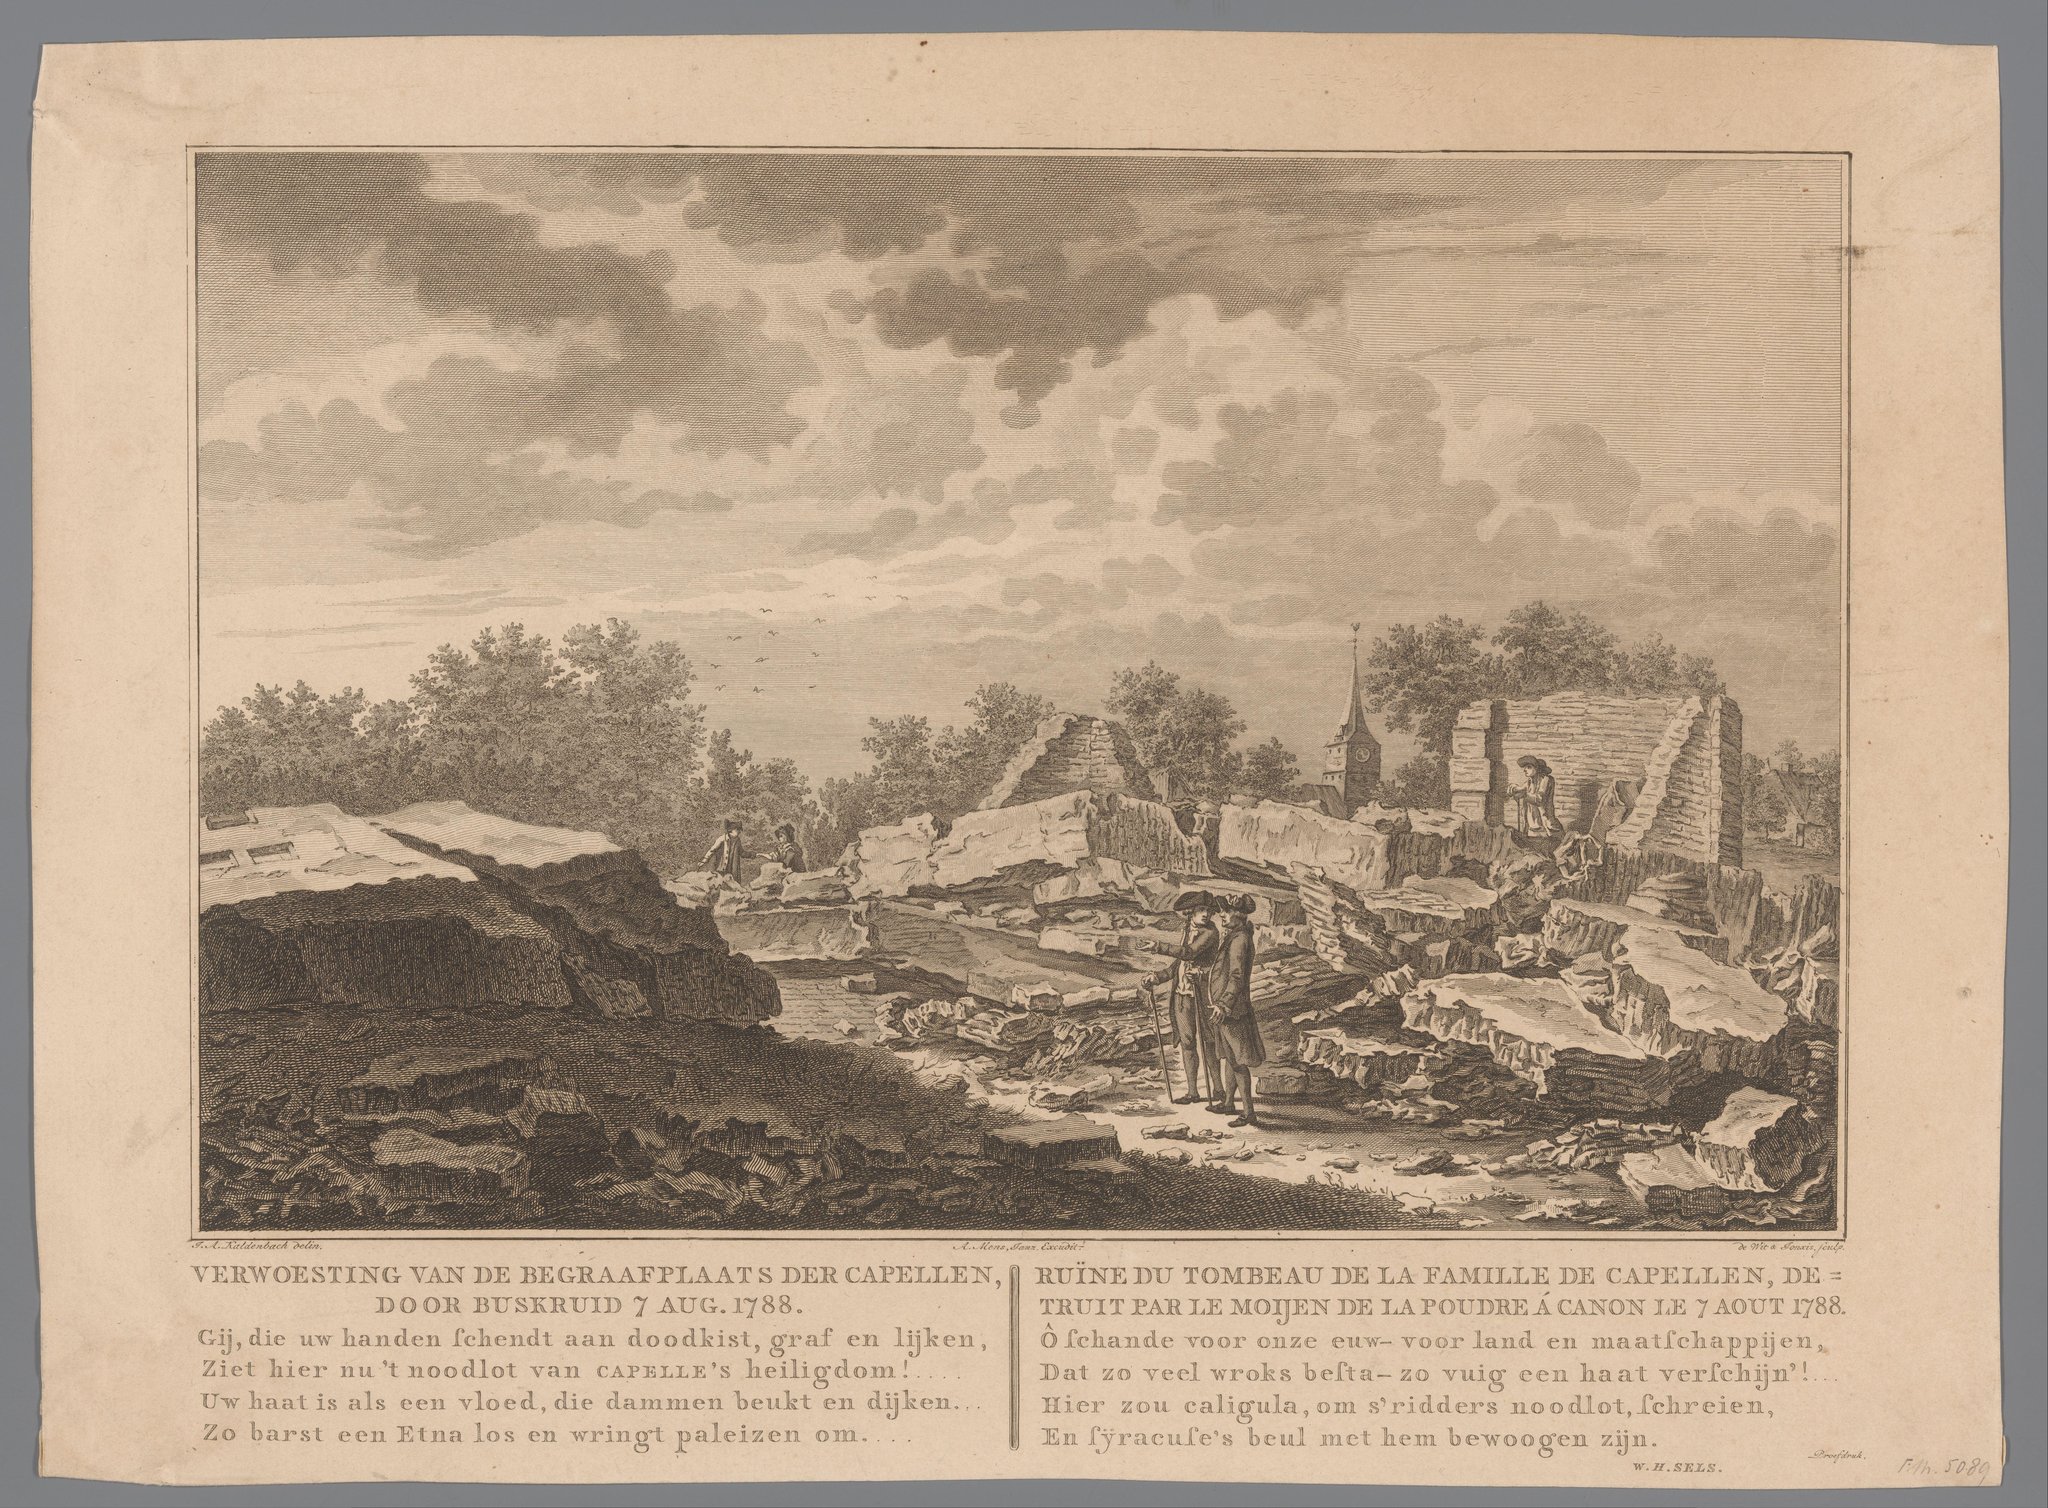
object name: print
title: Ruïne van de begraafplaats van de familie Van der Capellen, 1788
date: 1788-1790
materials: paper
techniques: etching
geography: netherlands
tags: joan derk van der capellen tot den pol, devastated, ruined place or city (~ warfare), grave-building, monumental tomb, gunpowder disaster, patriots (1780-1795)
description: Gezicht op de ruïnes van het familiegraf van de familie Van der Capellen in het Gorsselse Veld bij Zutphen, na de verwoesting door buskruit, 7 augustus 1788. Met achtregelig vers in het onderschrift.